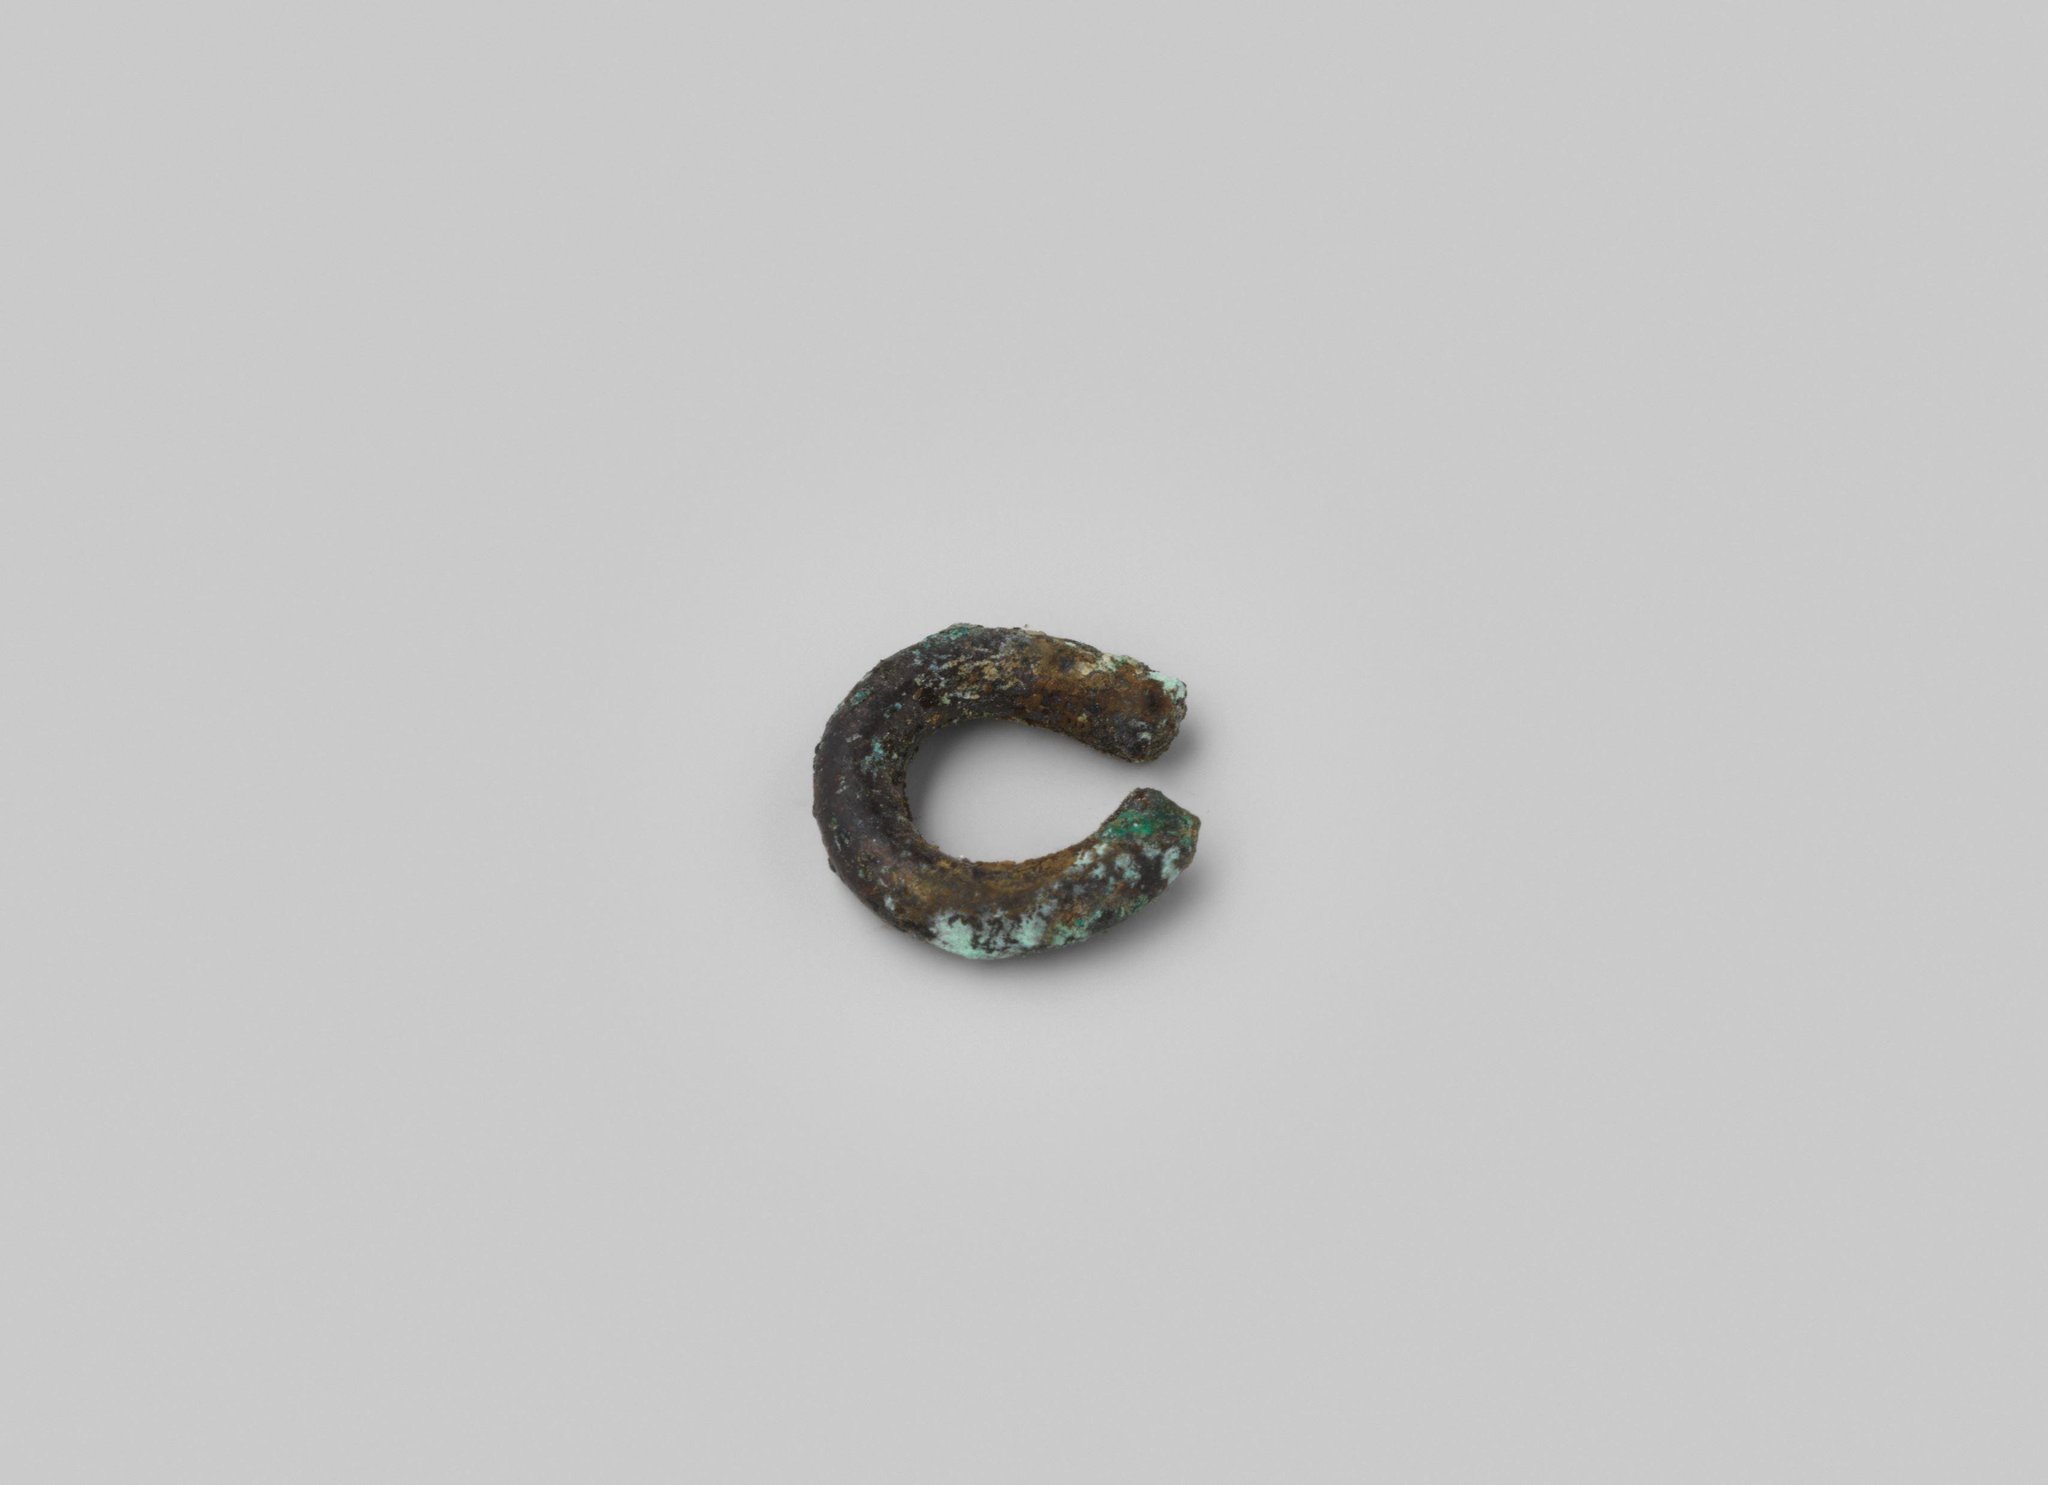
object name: screw eye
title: Schroefoog afkomstig uit het wrak van de Oost-Indiëvaarder Hollandia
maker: Anonymous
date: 1700-1743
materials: copper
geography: netherlands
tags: verenigde oostindische compagnie, hollandia (schip)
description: Screw eyes; fragm, looped eye, id. 80H3125.